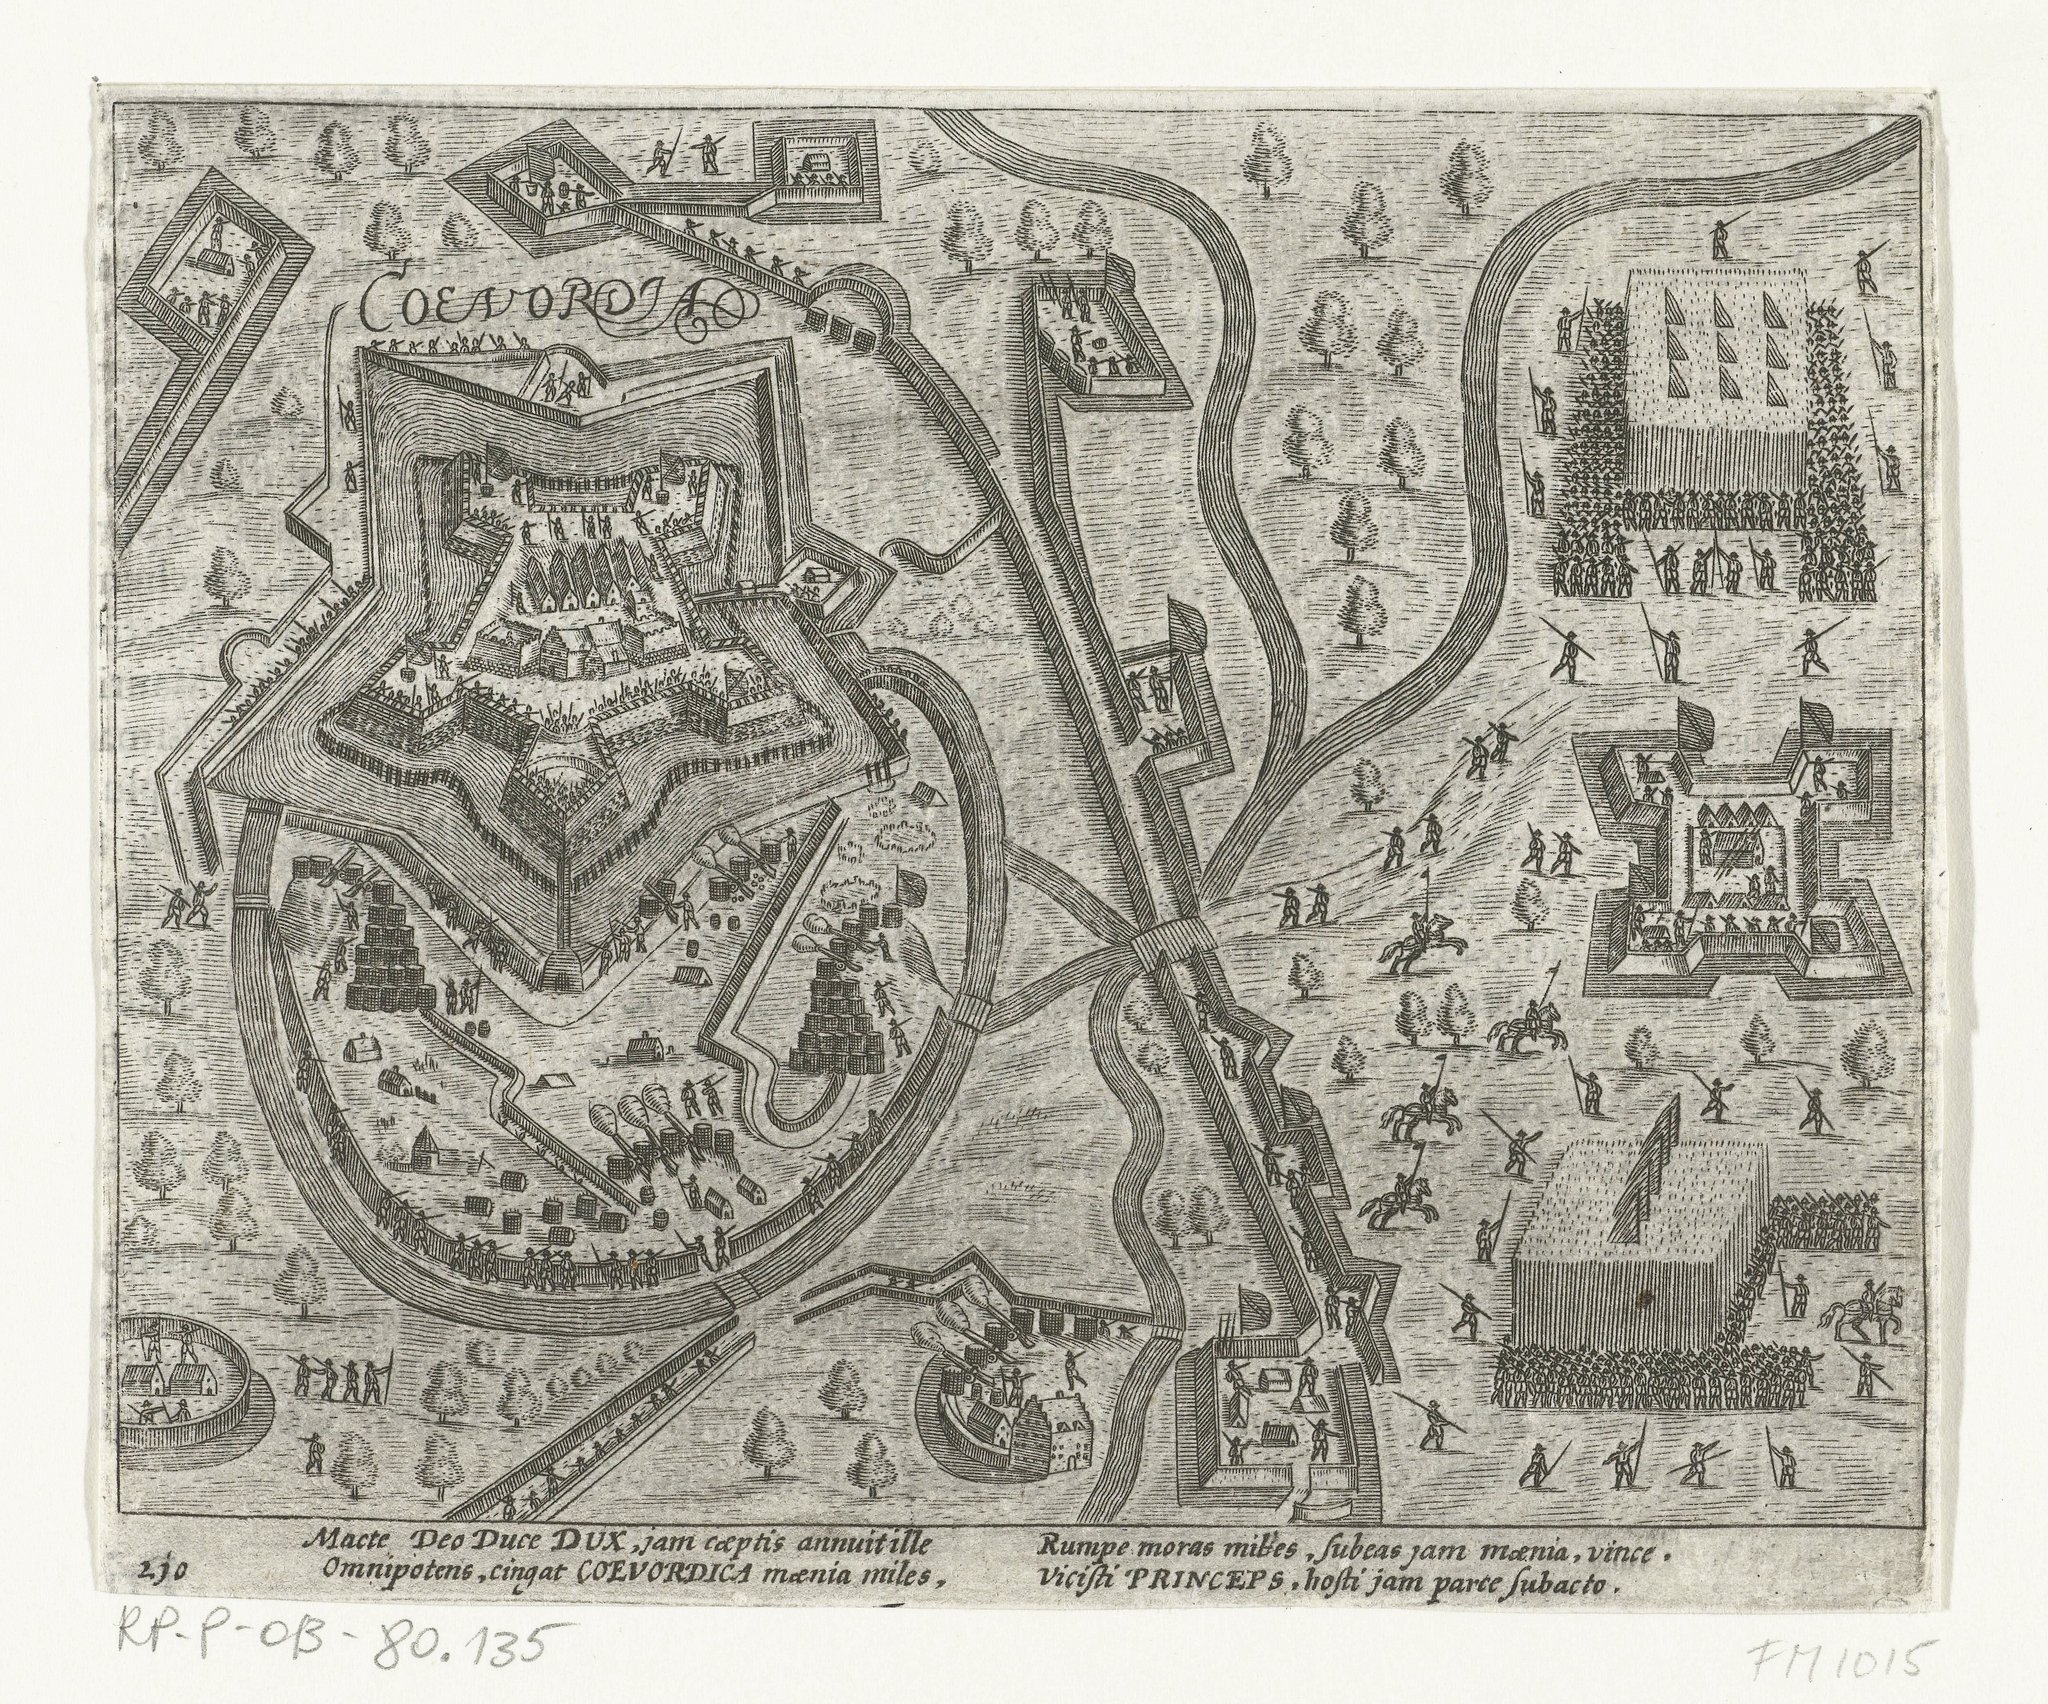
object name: history print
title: Beleg van Coevorden, 1592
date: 1613-1615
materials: paper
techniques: engraving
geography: northern netherlands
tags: maurice (prince of orange), siege, position war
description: Beleg van Coevorden door het Staatse leger onder Maurits en Willem Lodewijk, juli - september 1592. Plan van de vesting met het kasteel Coevorden met het omringende land met de posities van de belegerende troepen. Met onderschrift van 4 regels in het Latijn. Genummerd 210. Bedrukt op achterzijde met tekst in het Latijn.